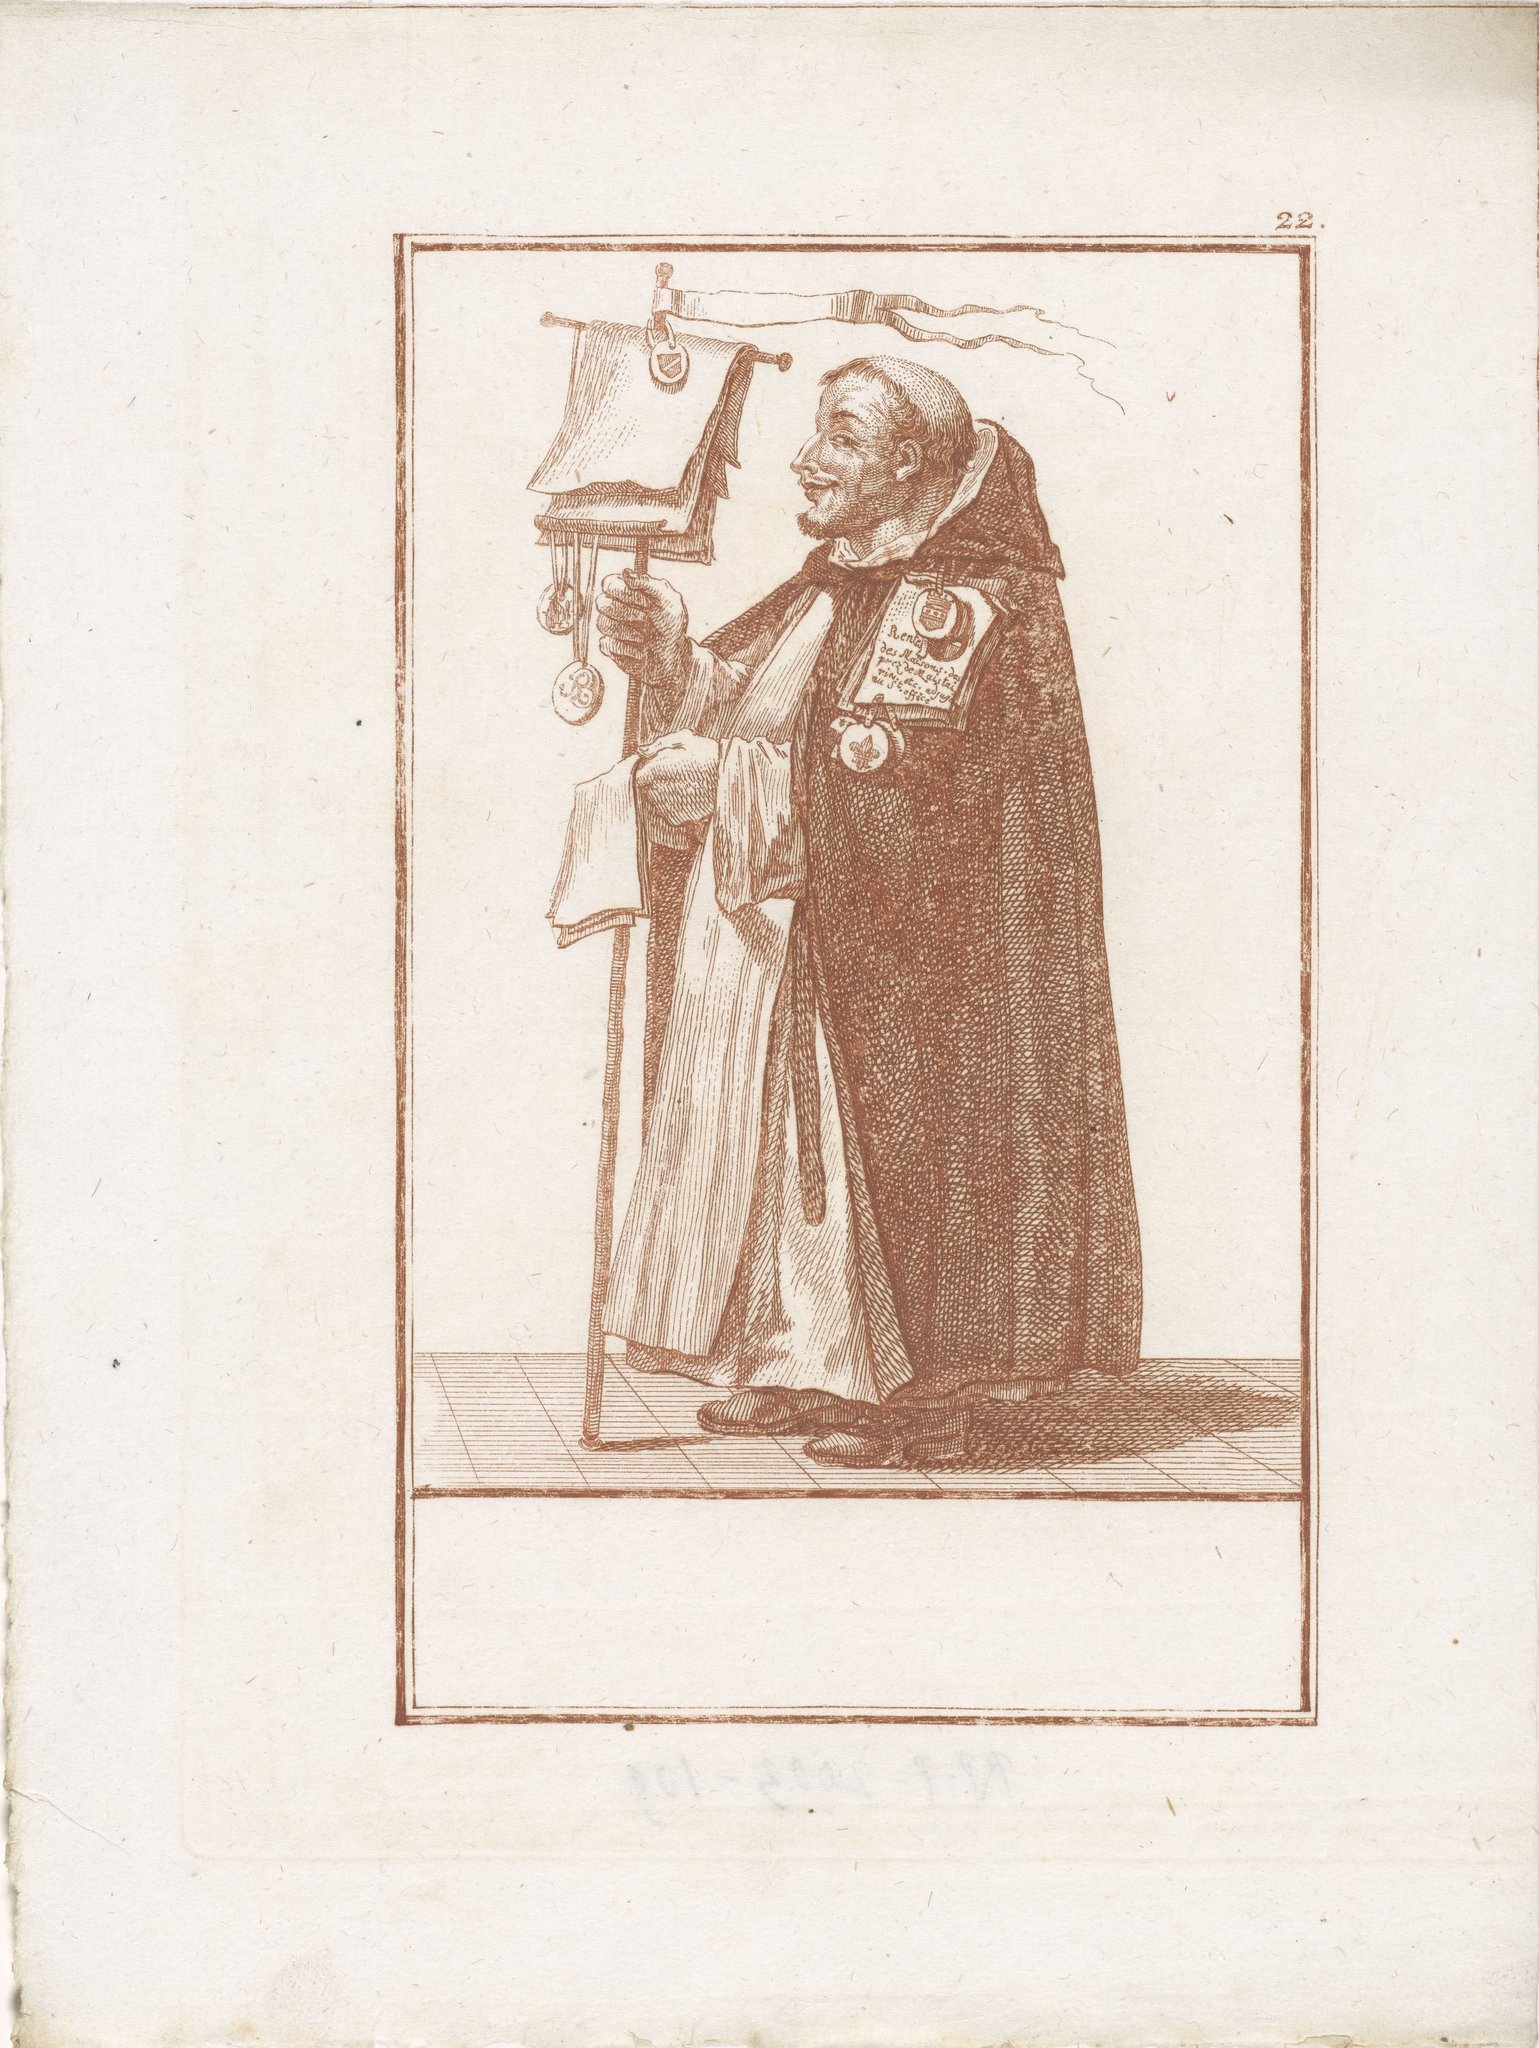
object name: print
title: Misbruiken van de katholieke geestelijkheid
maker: jacob gole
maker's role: print maker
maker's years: 1660-1724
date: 1724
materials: paper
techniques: etching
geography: amsterdam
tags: monk(s), friar(s), (aspects of) christian religion or the church (as institution) ridiculed, criticized, or caricaturized, indulgence ~ confession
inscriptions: collector's mark: Lugt 2760, collector's mark: Lugt 2228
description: Monnik met een standaard waaraan aflaatbrieven hangen. In zijn rechterhand eveneens aflaatbrieven. De prent is deel van een 50-delige serie met als onderwerp de misbruiken van de katholieke geestelijkheid.